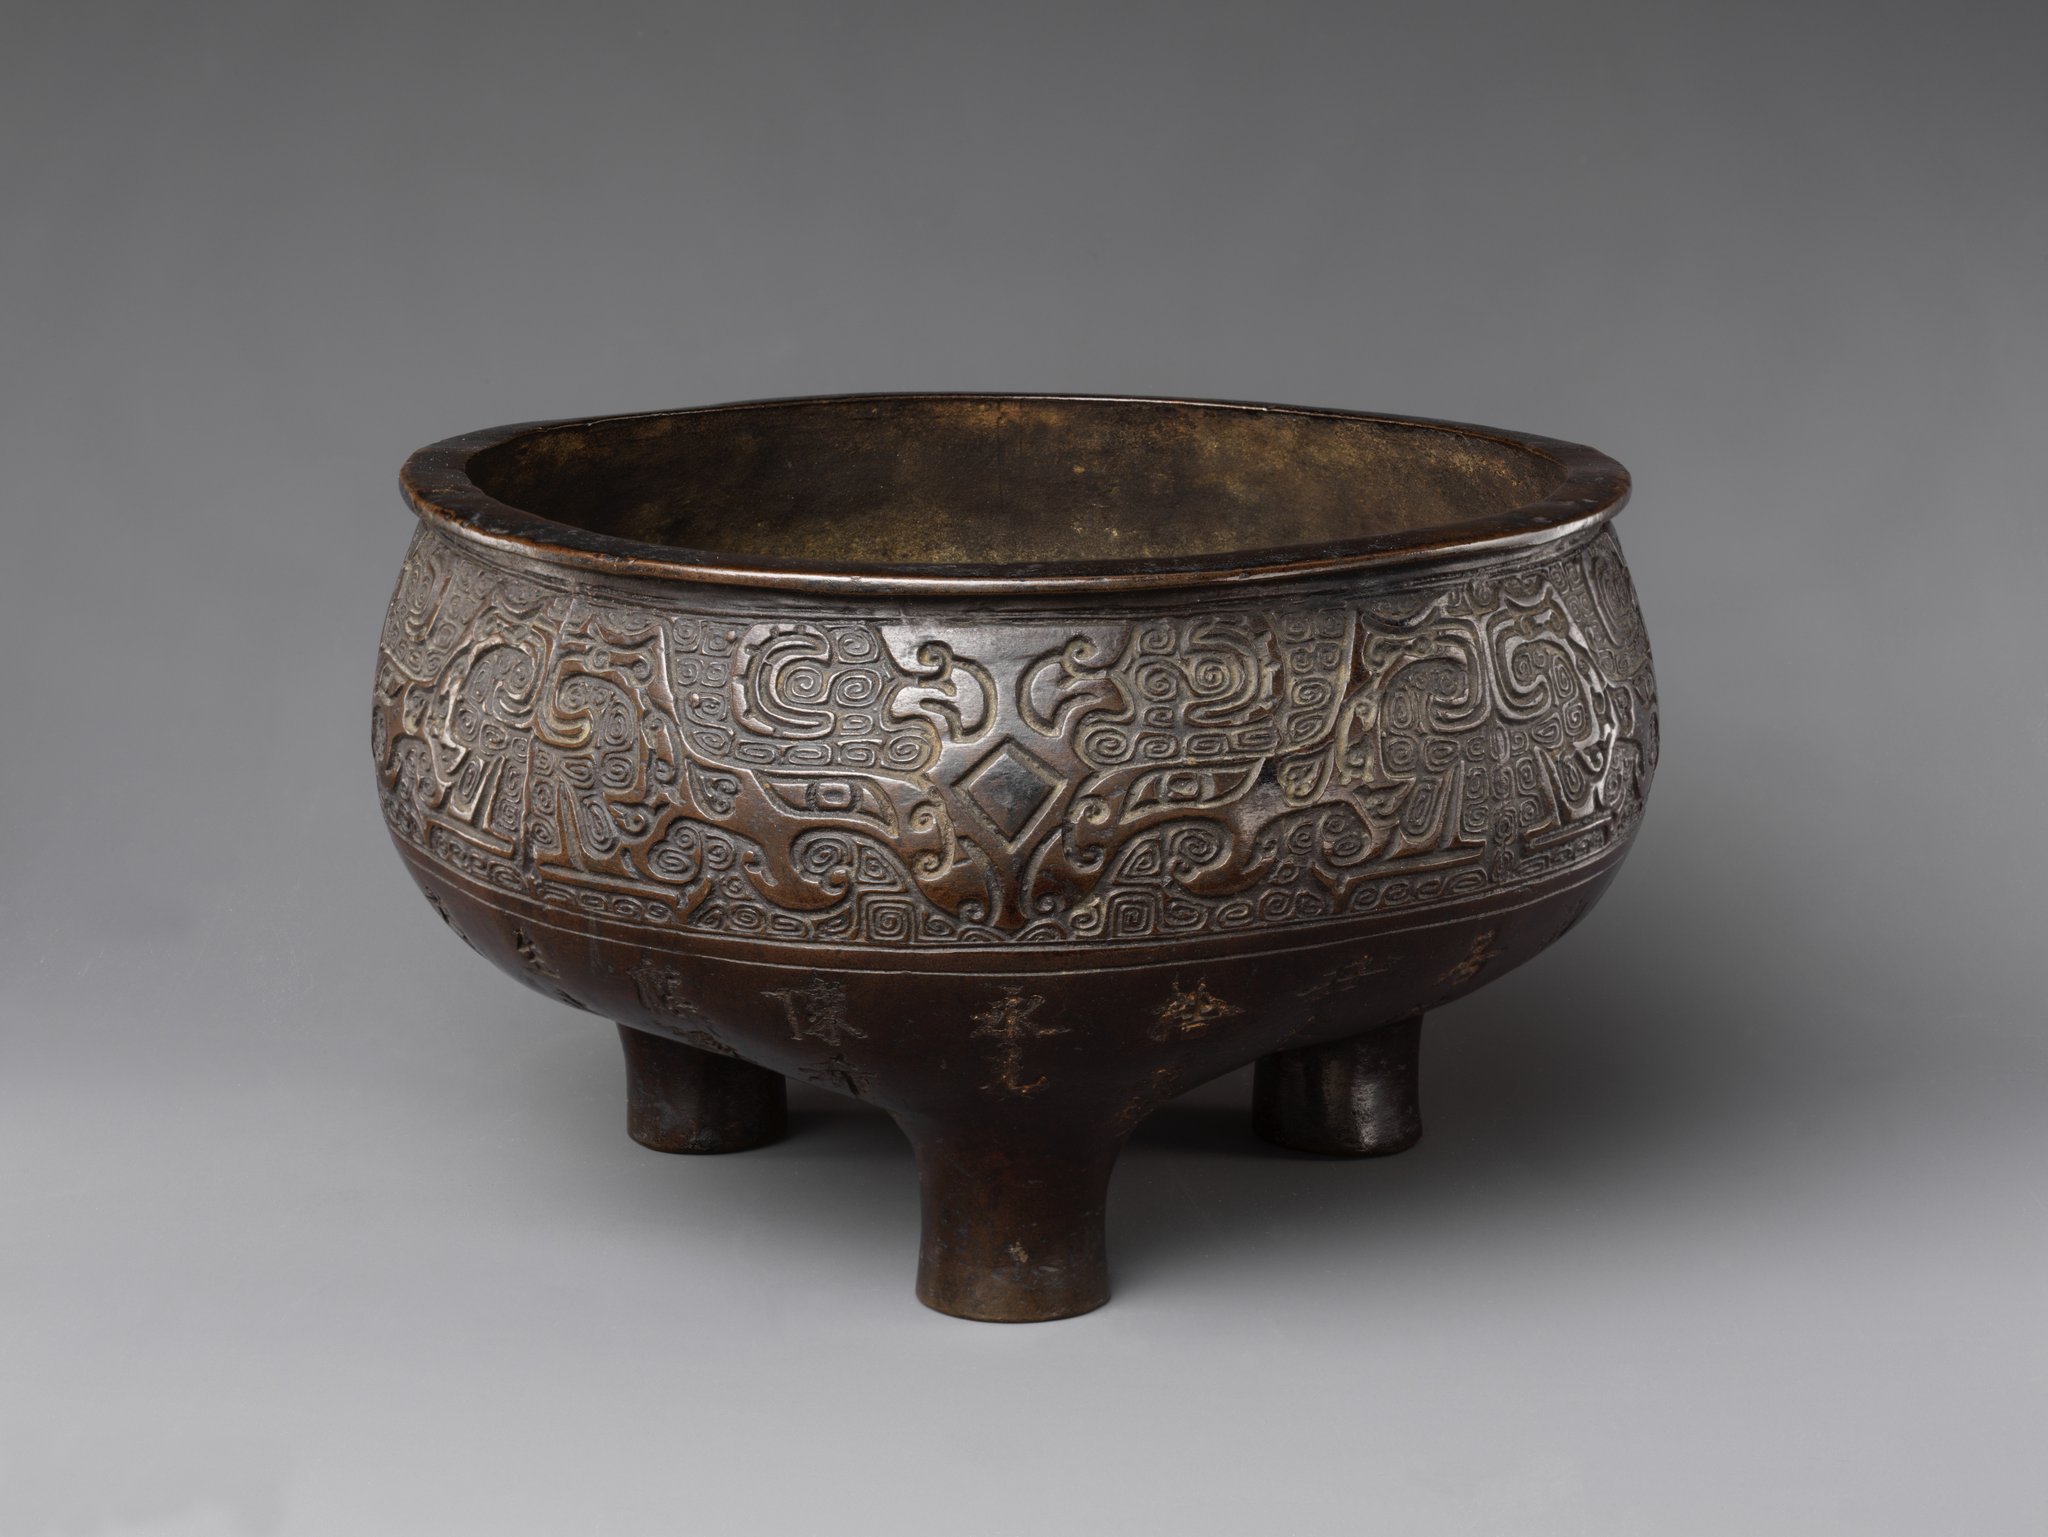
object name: incense burner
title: Tripod incense burner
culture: chinese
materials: copper alloy